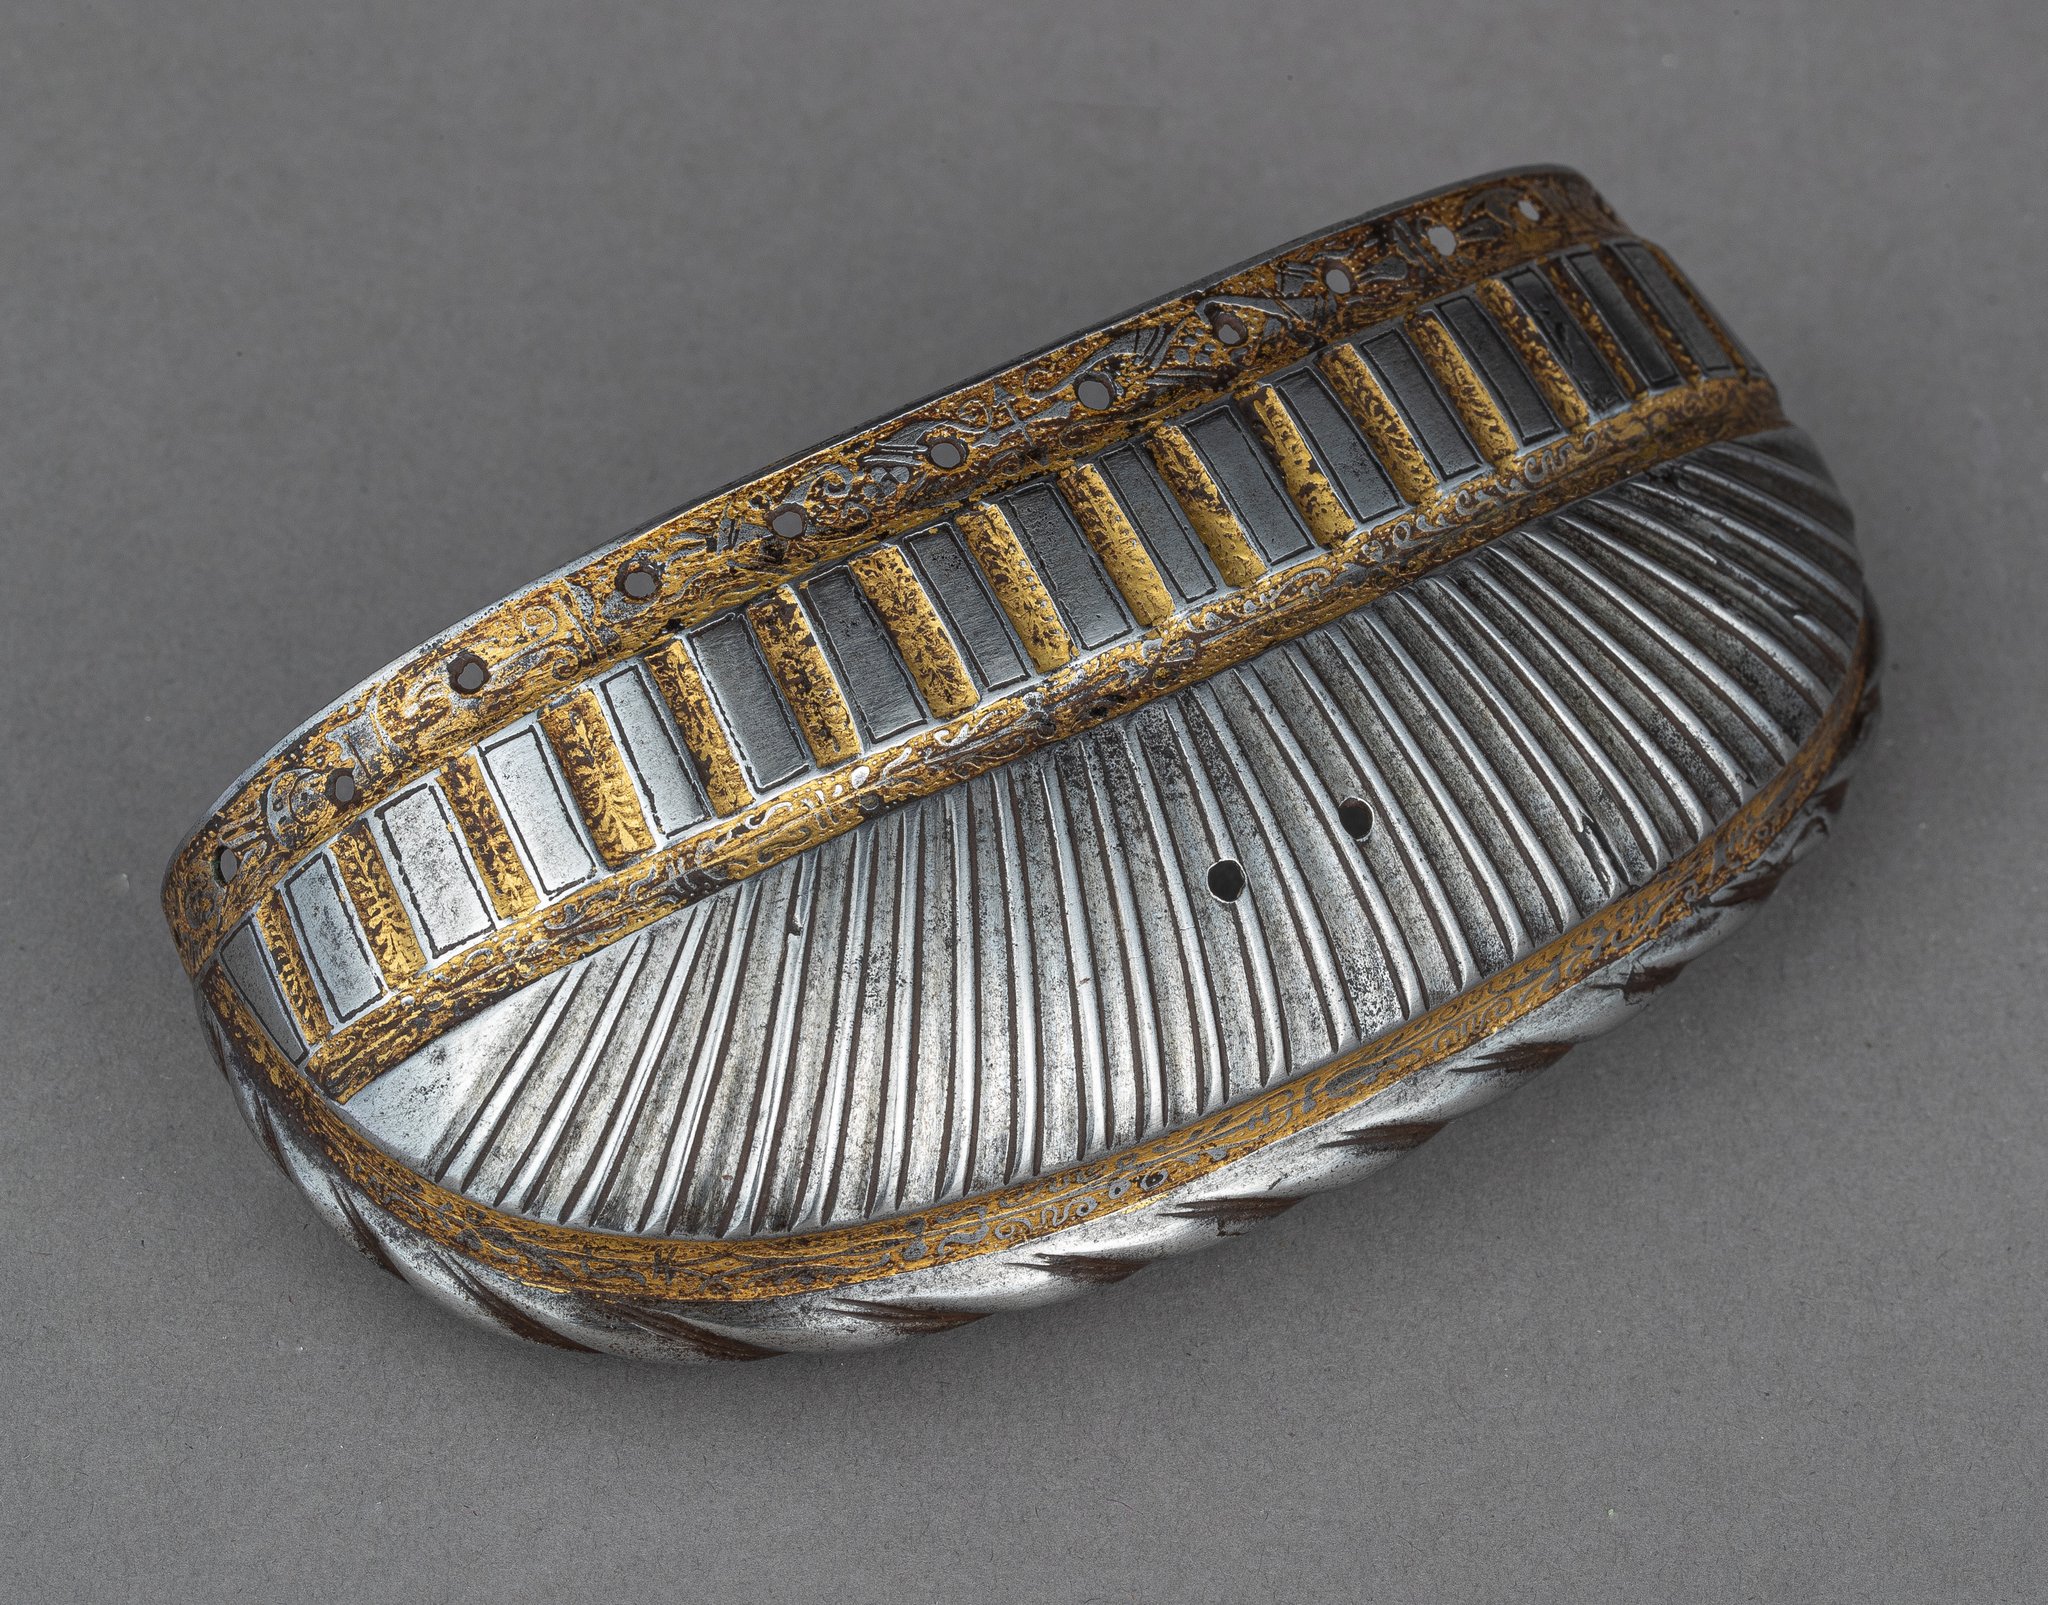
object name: toe cap for a foot defense sabaton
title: Toe Cap for a Foot Defense (Sabaton)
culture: german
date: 1520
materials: gold, steel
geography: germany